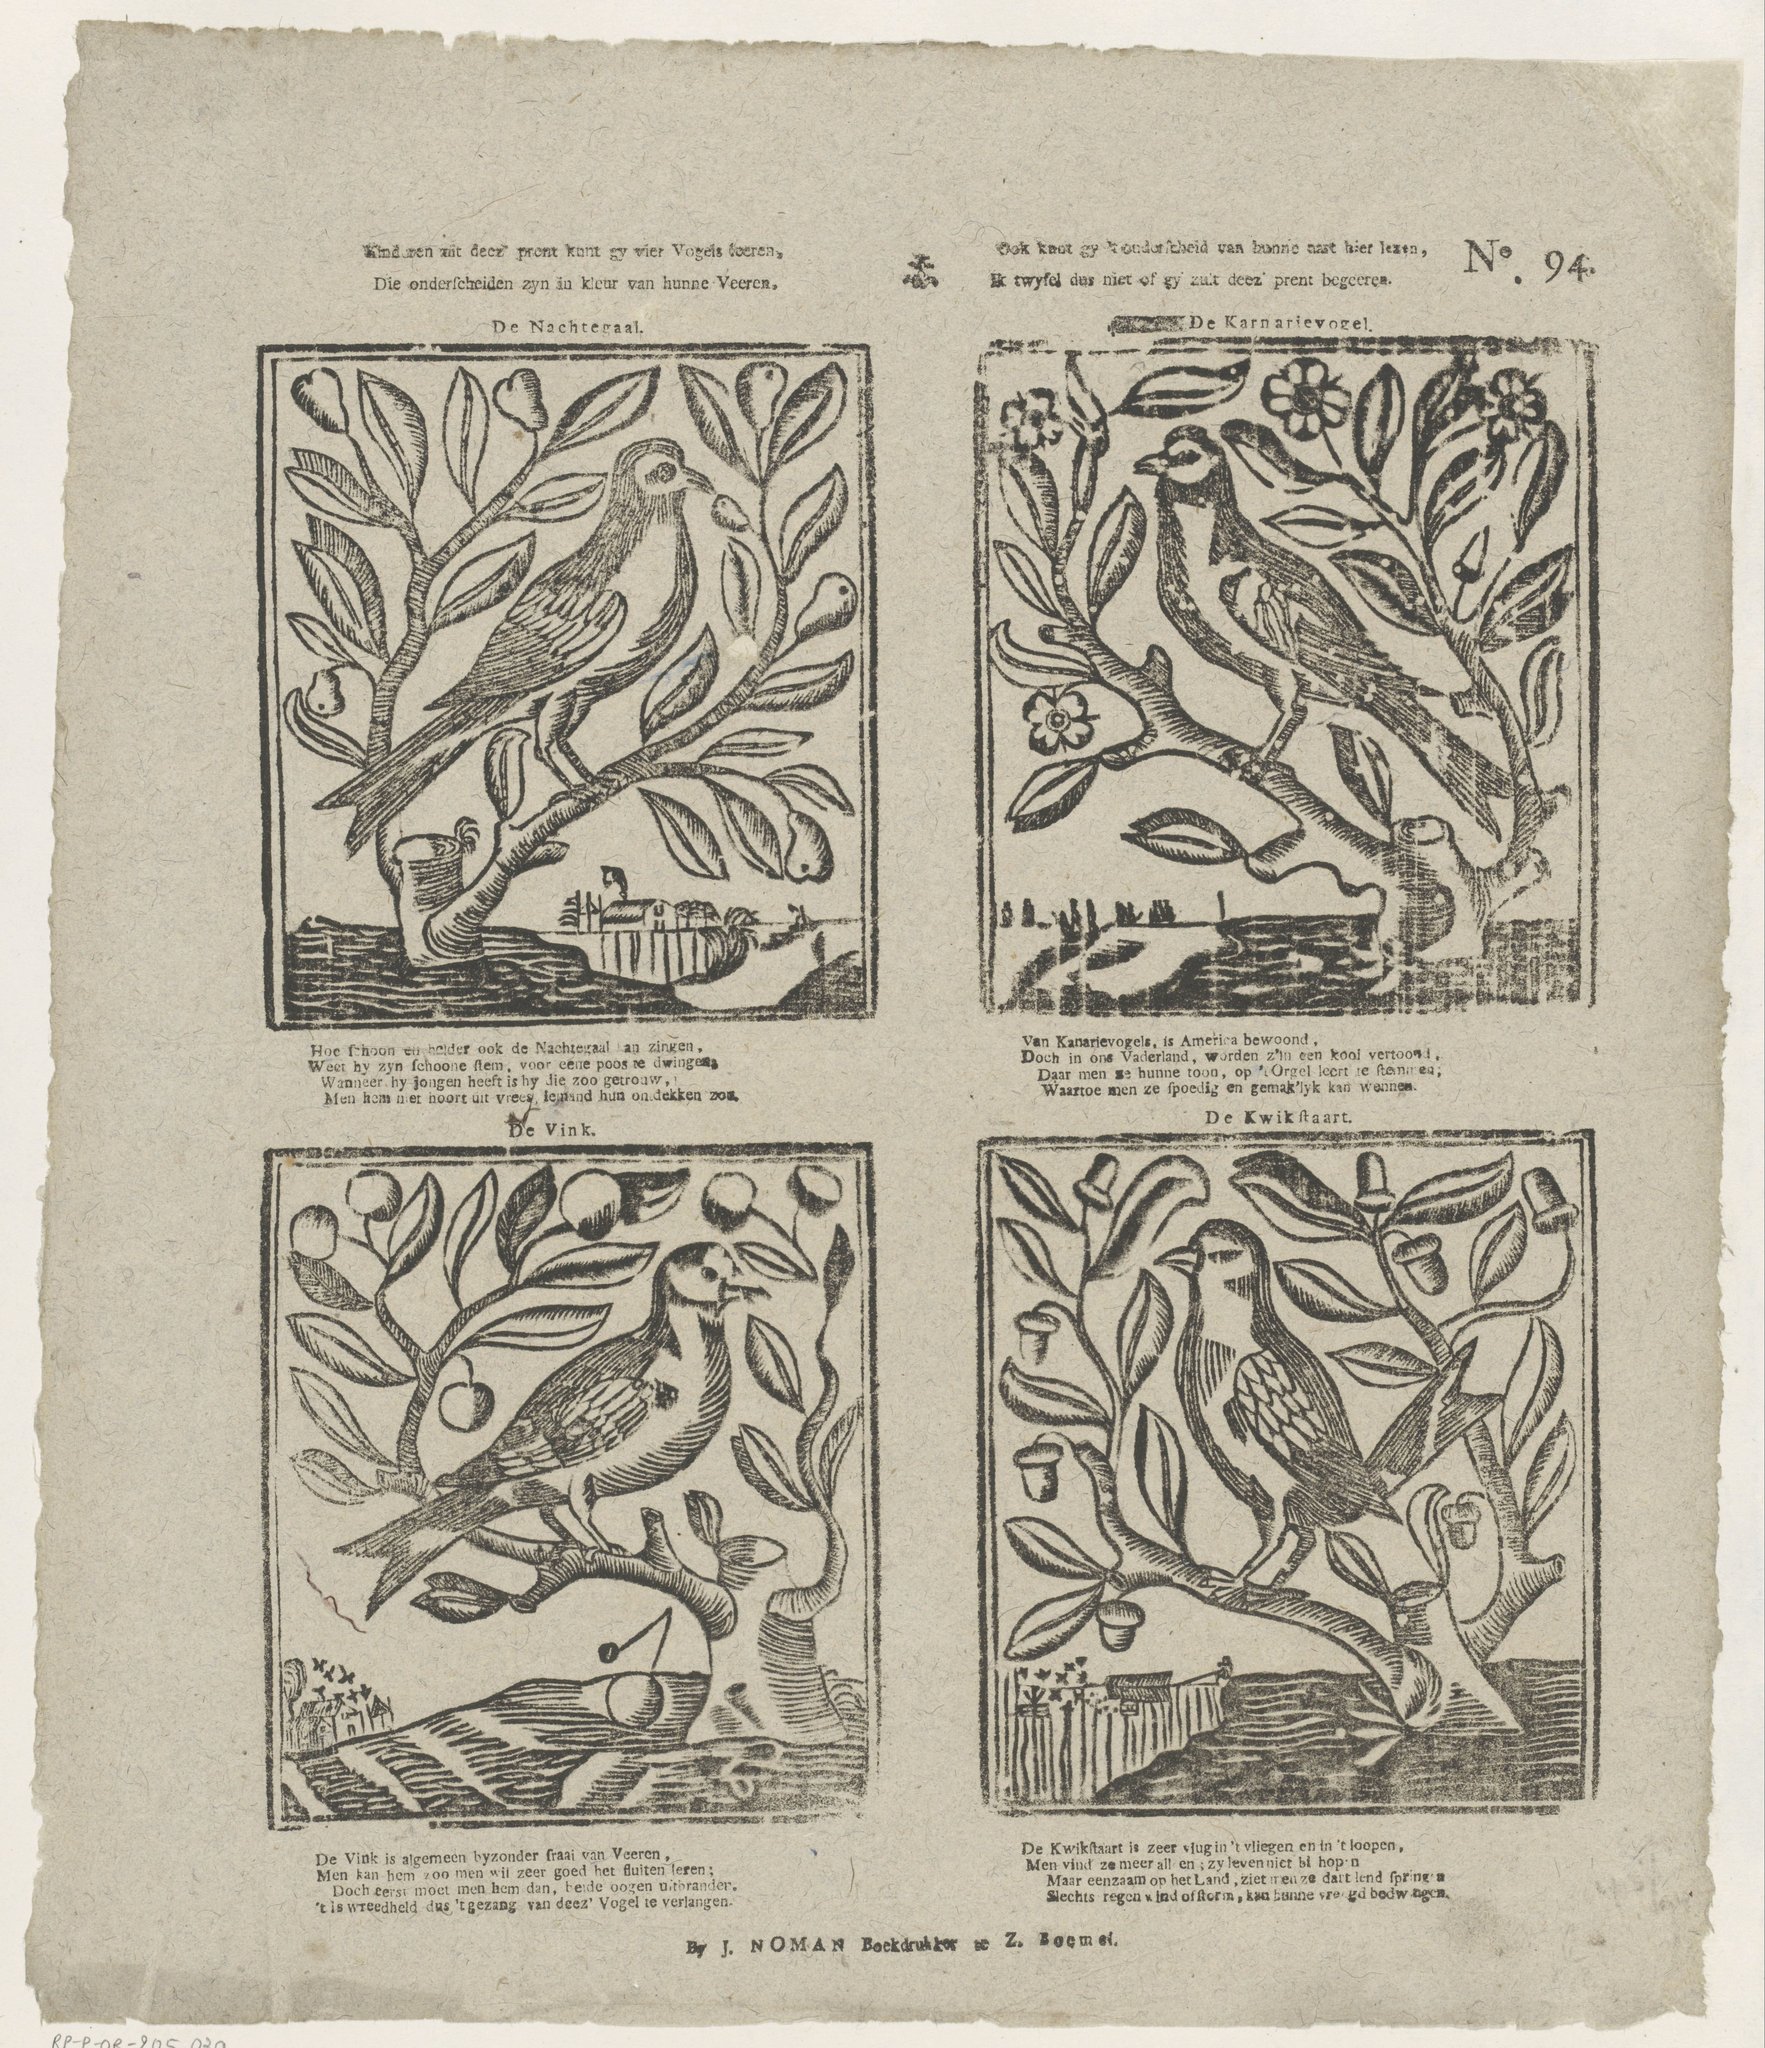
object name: popular print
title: Kinderen uit deez' prent kont gy vier vogels leeren, / Die onderscheiden zyn in kleur van hunne veeren [(...)]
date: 1806-1830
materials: paper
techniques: colour, letterpress printing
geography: netherlands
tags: birds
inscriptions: collector's mark: Lugt 2760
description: Blad met 4 voorstellingen van vogels: een nachtegaal, een kanarie, een vink en een kwikstaartje. Onder elke afbeelding een vierregelig vers, boven elke afbeelding een titel. Genummerd rechtsboven: No. 94.